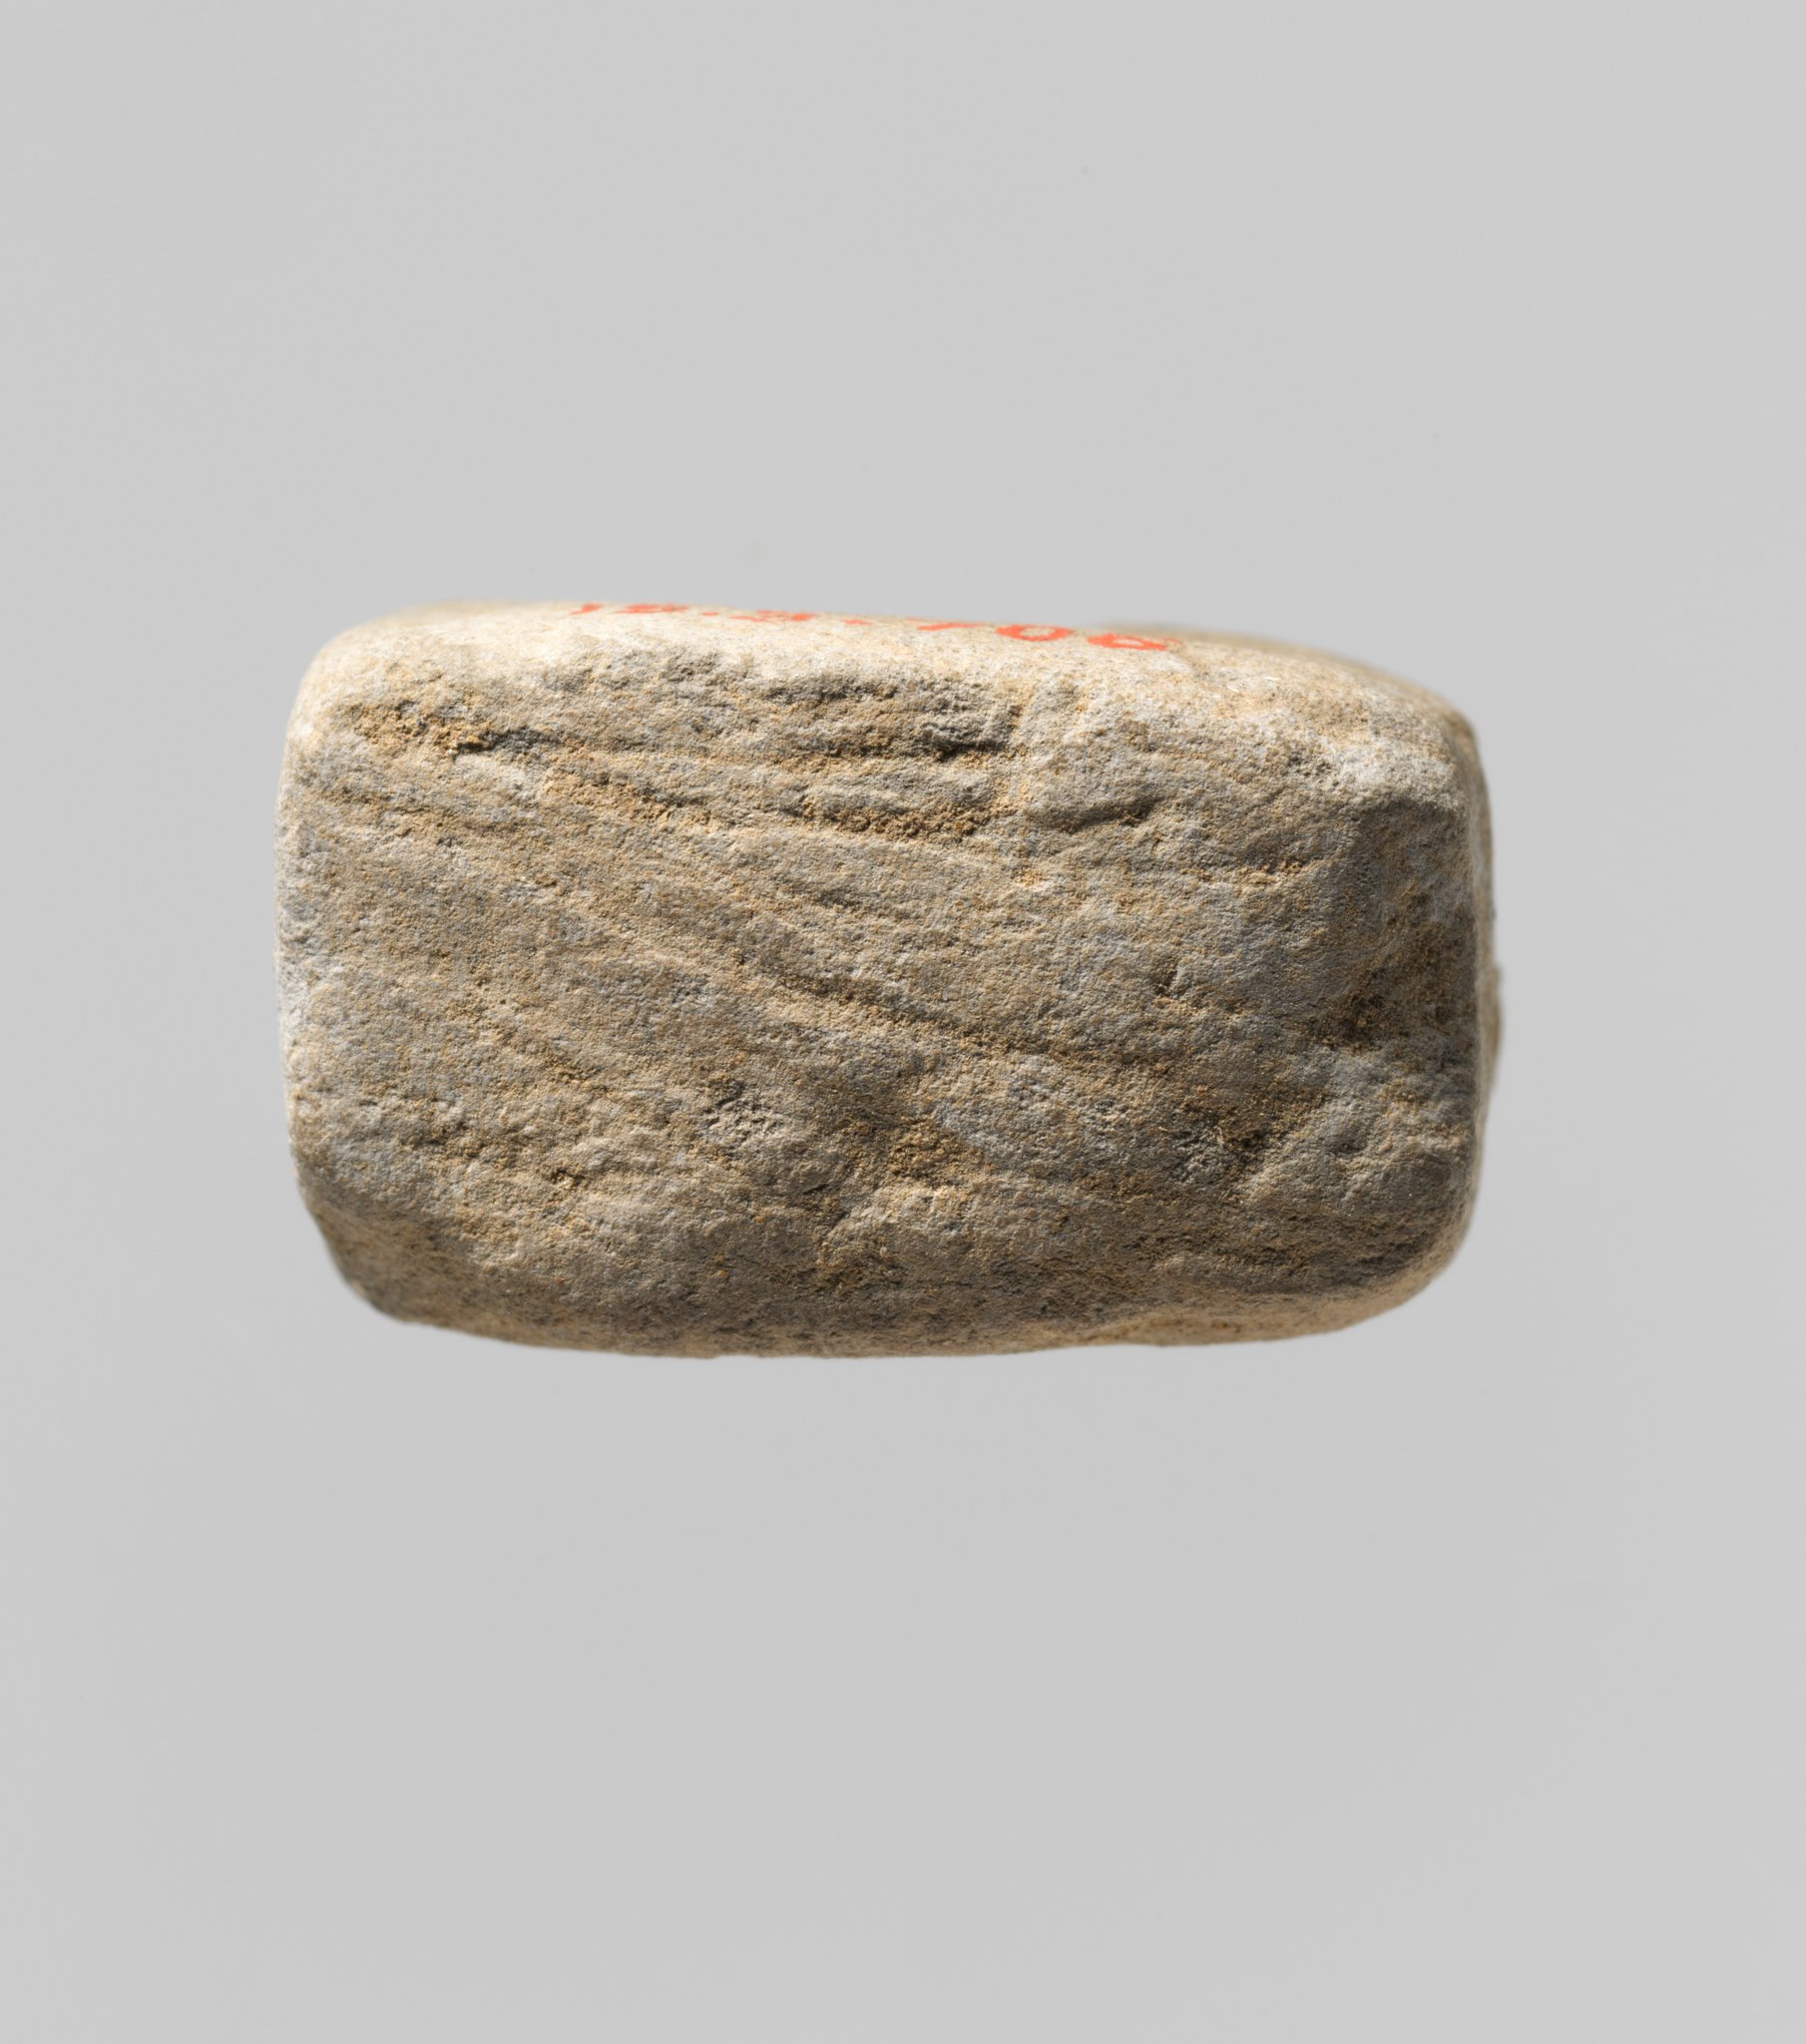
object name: stamp, disk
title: Stamp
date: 1295-1070 BCE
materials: limestone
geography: egypt